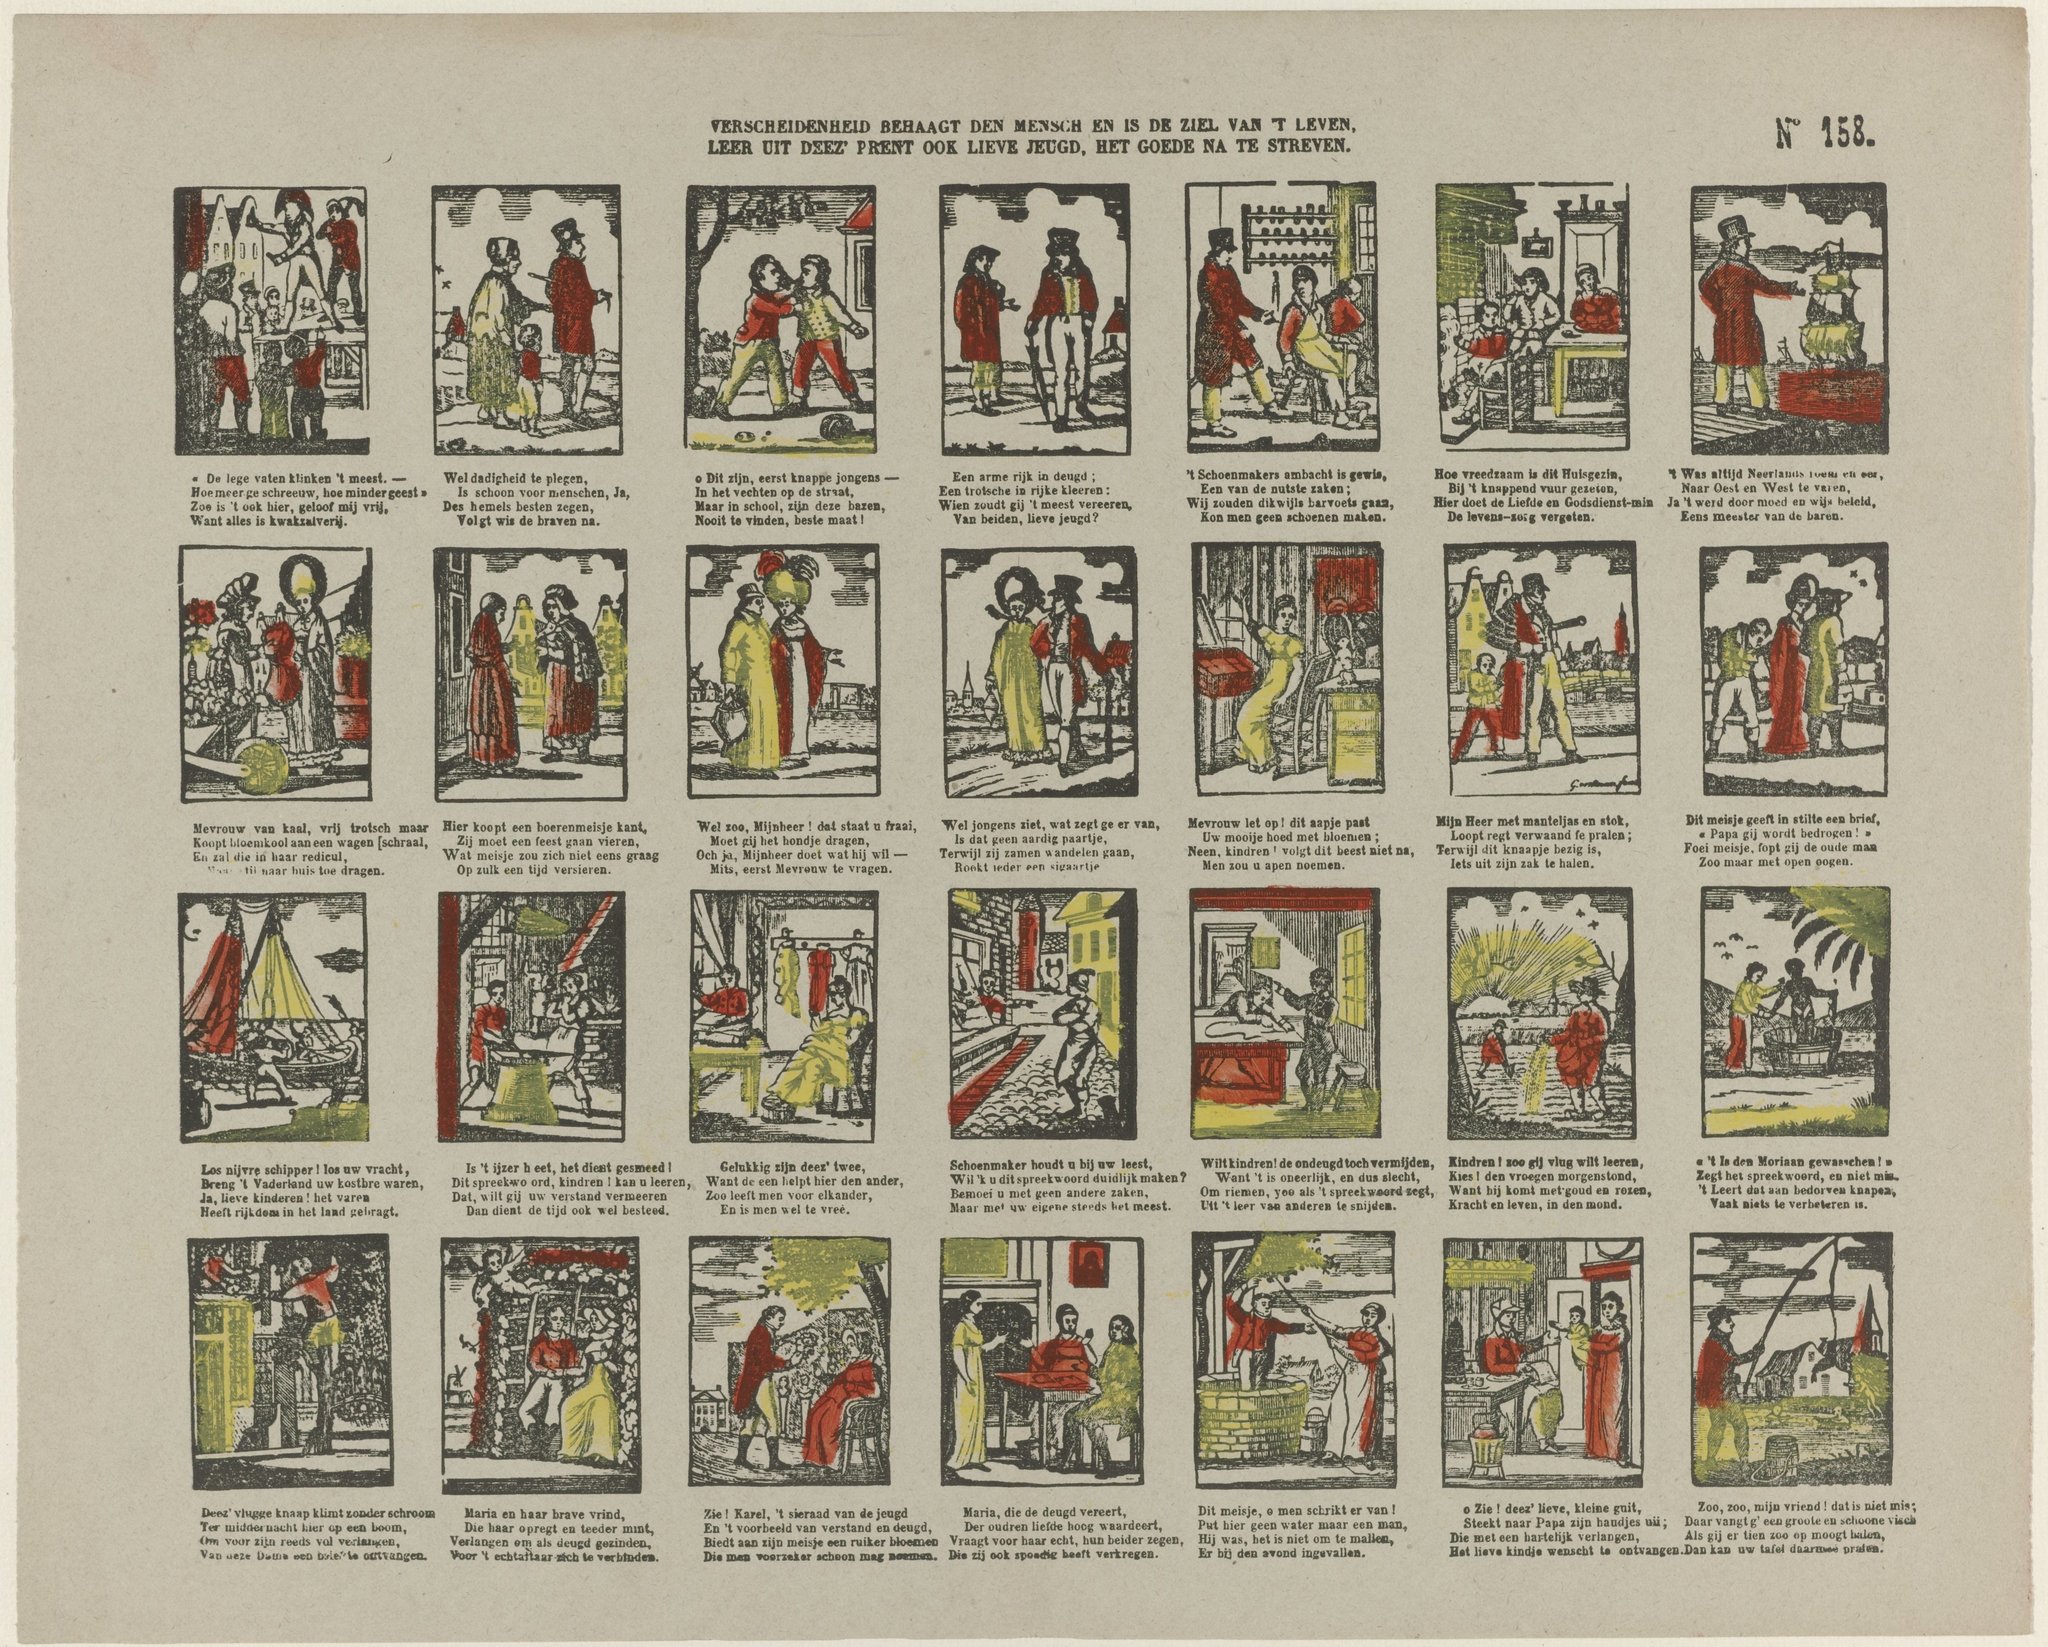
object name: print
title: Verscheidenheid behaagt den mensch en is de ziel van 't leven, / Leer uit deez' prent ook lieve jeugd, het goede na te streven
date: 1827-1894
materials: paper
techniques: colour, letterpress printing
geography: netherlands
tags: craft-production, skilled handiwork, characters (human types), crafts and industries, fighting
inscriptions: collector's mark: Lugt 2760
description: Blad met 28 voorstellingen van verschillende aard, waaronder voorstellingen van een kwakzalver, vechtende kinderen, een smid en een meid die een man uit een waterput ophijst. Onder elke afbeelding een vierregelig vers. Genummerd rechtsboven: No 158.